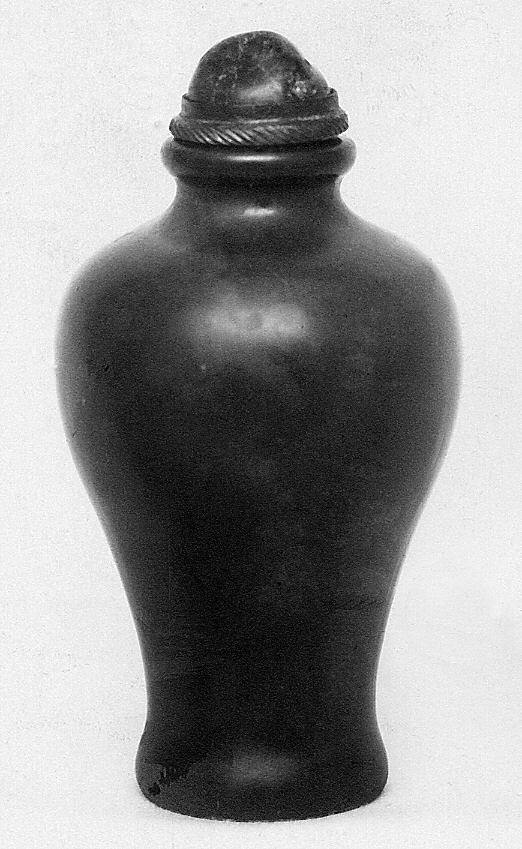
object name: snuff bottle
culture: chinese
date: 1736-1795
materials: porcelain